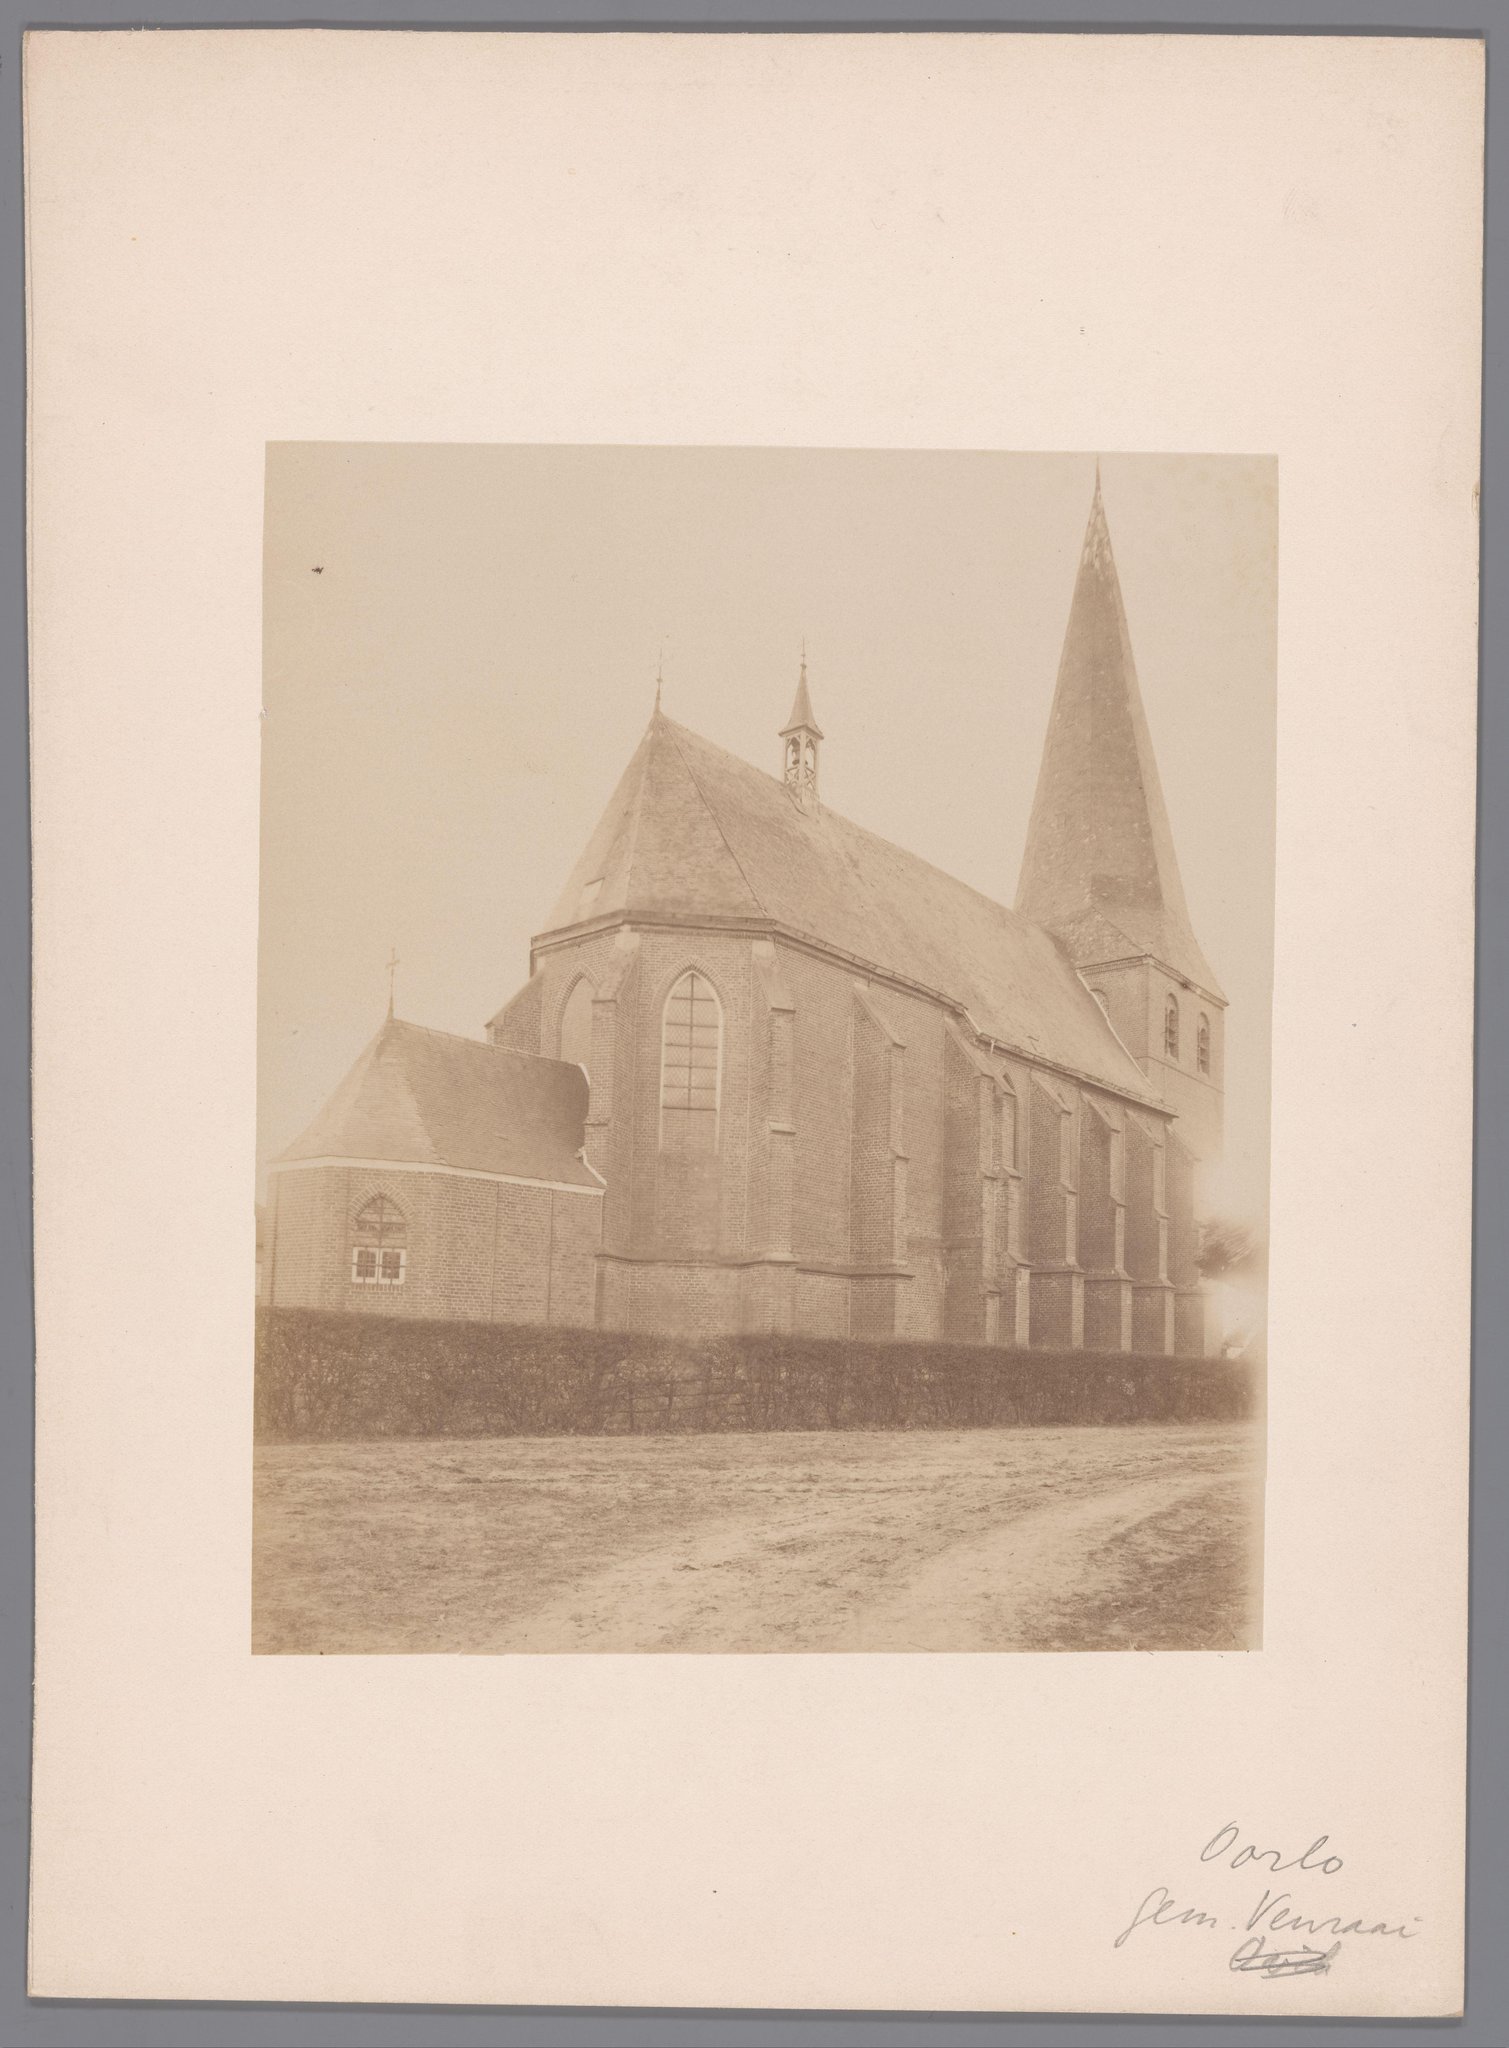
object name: photograph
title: Noordoostzijde van de Sint-Gertrudiskerk te Oirle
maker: anoniem (monumentenzorg)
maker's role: fotograaf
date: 1904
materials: cardboard, photographic support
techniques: albumen print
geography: venray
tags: church (exterior)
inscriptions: annotation: ‘Oirle gemeente Venraai (Limburg)/ R.K. Kerk/ feb 1904’, annotation: ‘Oorlo/ gem. Venraai’